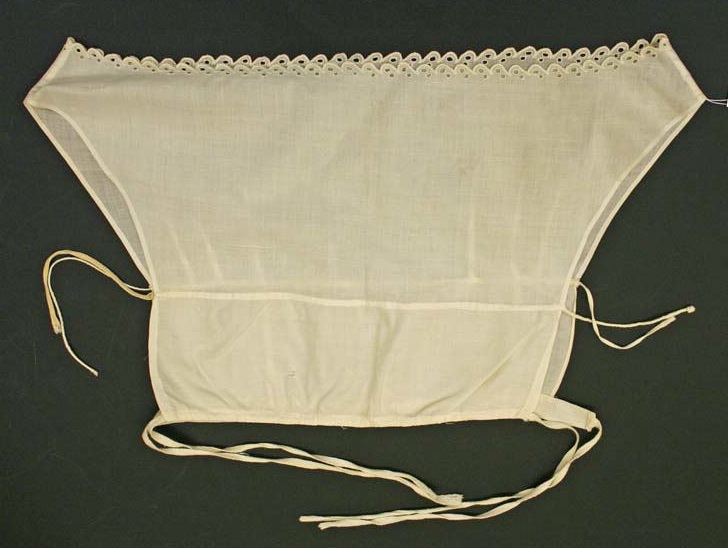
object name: waist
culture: american or european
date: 1799-1820